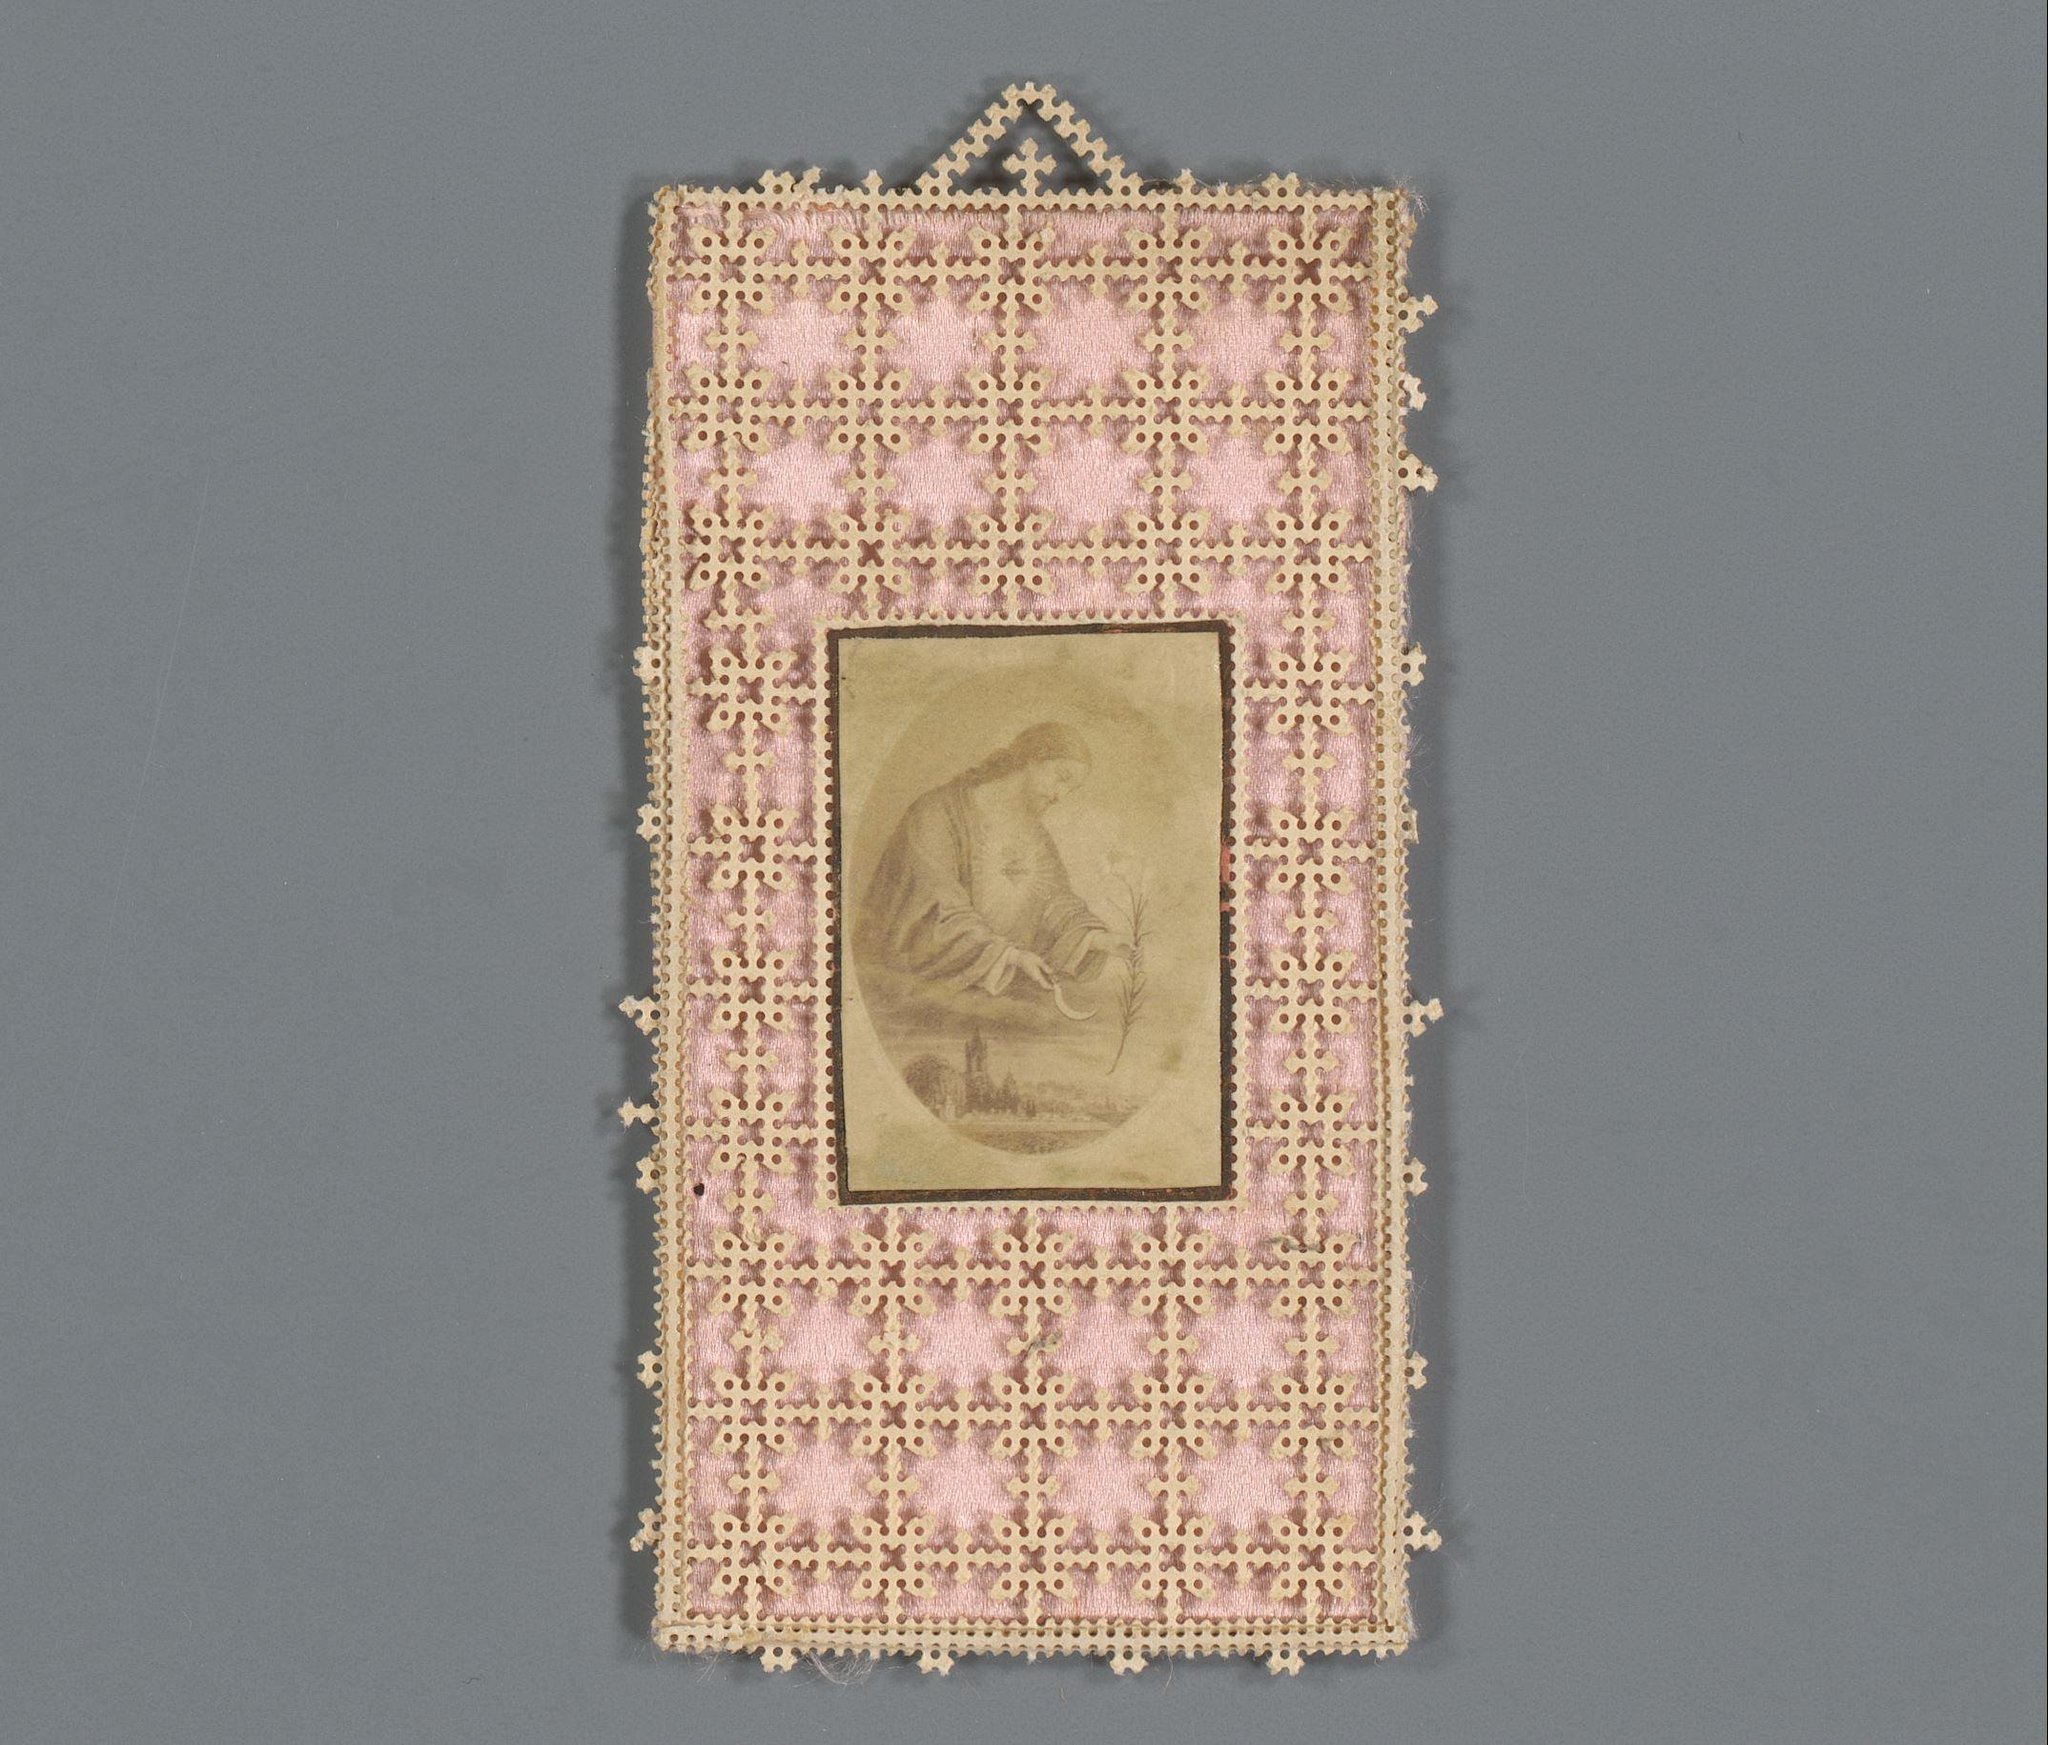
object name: reproduction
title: Fotoreproductie van een schilderij van Christus met het Heilig Hart en sikkel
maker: Anonymous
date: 1851-1900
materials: paper, silk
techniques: albumen print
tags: the sacred heart